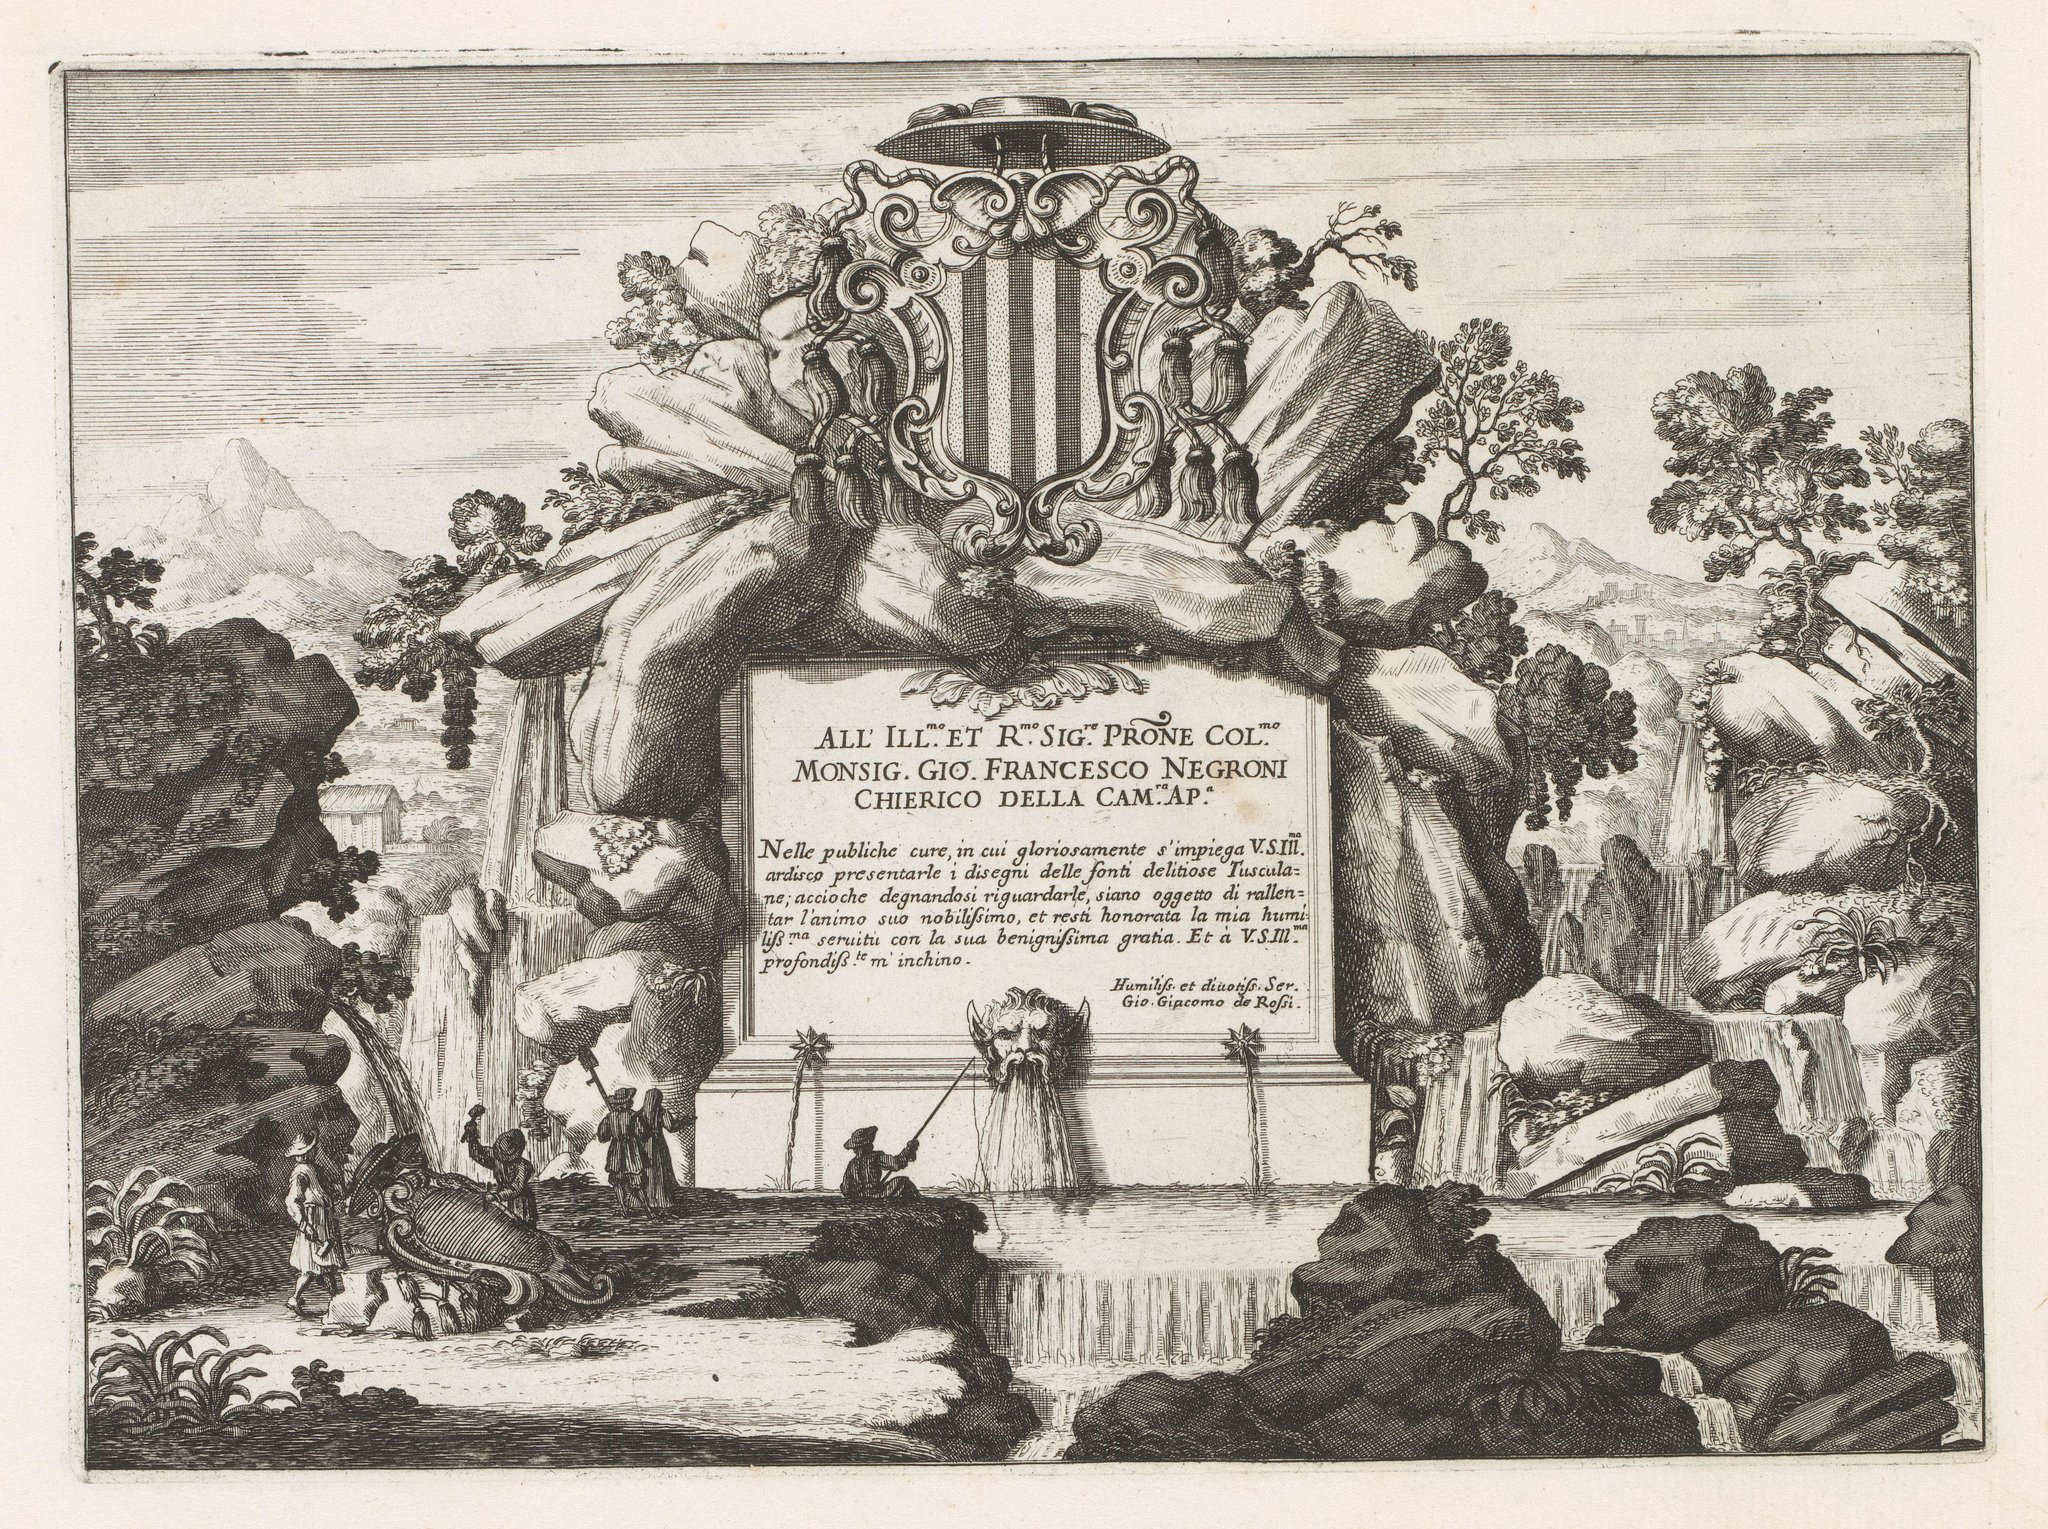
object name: print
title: Fonteinen van Frascati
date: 1653-1691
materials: paper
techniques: engraving, etching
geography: rome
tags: tools, aids, implements ~ crafts and industries: chisel, ornamental fountain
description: In het midden een fontein met een opdracht aan en het wapen van kardinaal Giovanni Francesco Negroni. Links op de voorgrond twee figuren die met hamer en beitel een schild voorzien van een wapen. De prent maakt deel uit van een album.